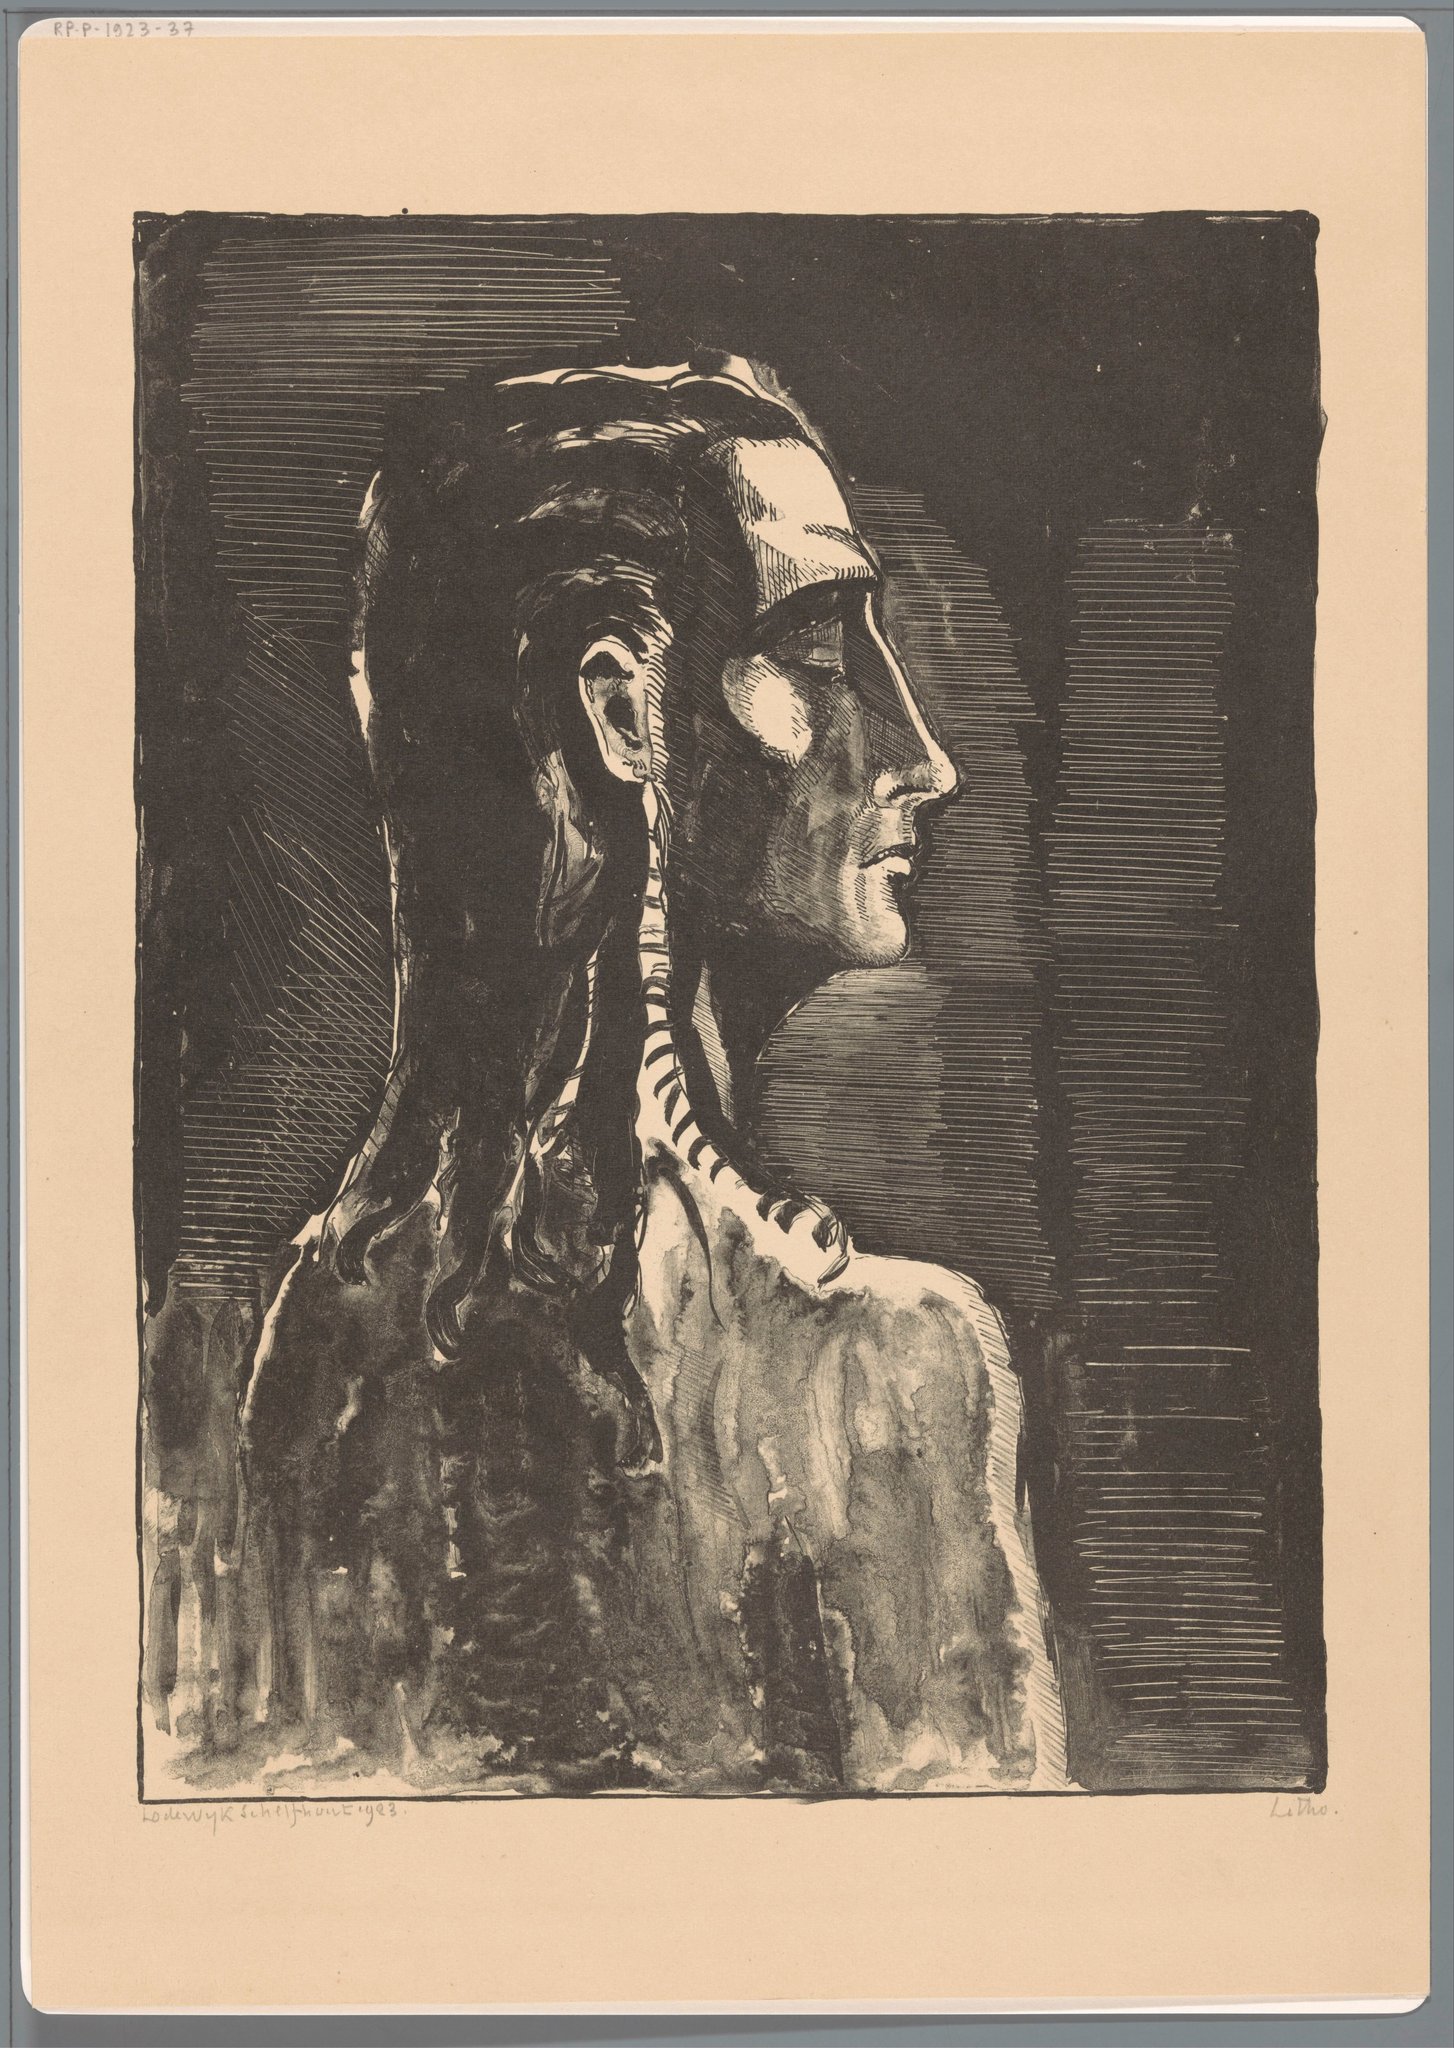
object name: print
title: Figuur met gesloten ogen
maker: lodewijk schelfhout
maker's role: draughtsman, print maker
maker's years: 1881-1943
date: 1923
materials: paper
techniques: lithograph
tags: eyes closed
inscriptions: collector's mark: Lugt 2228